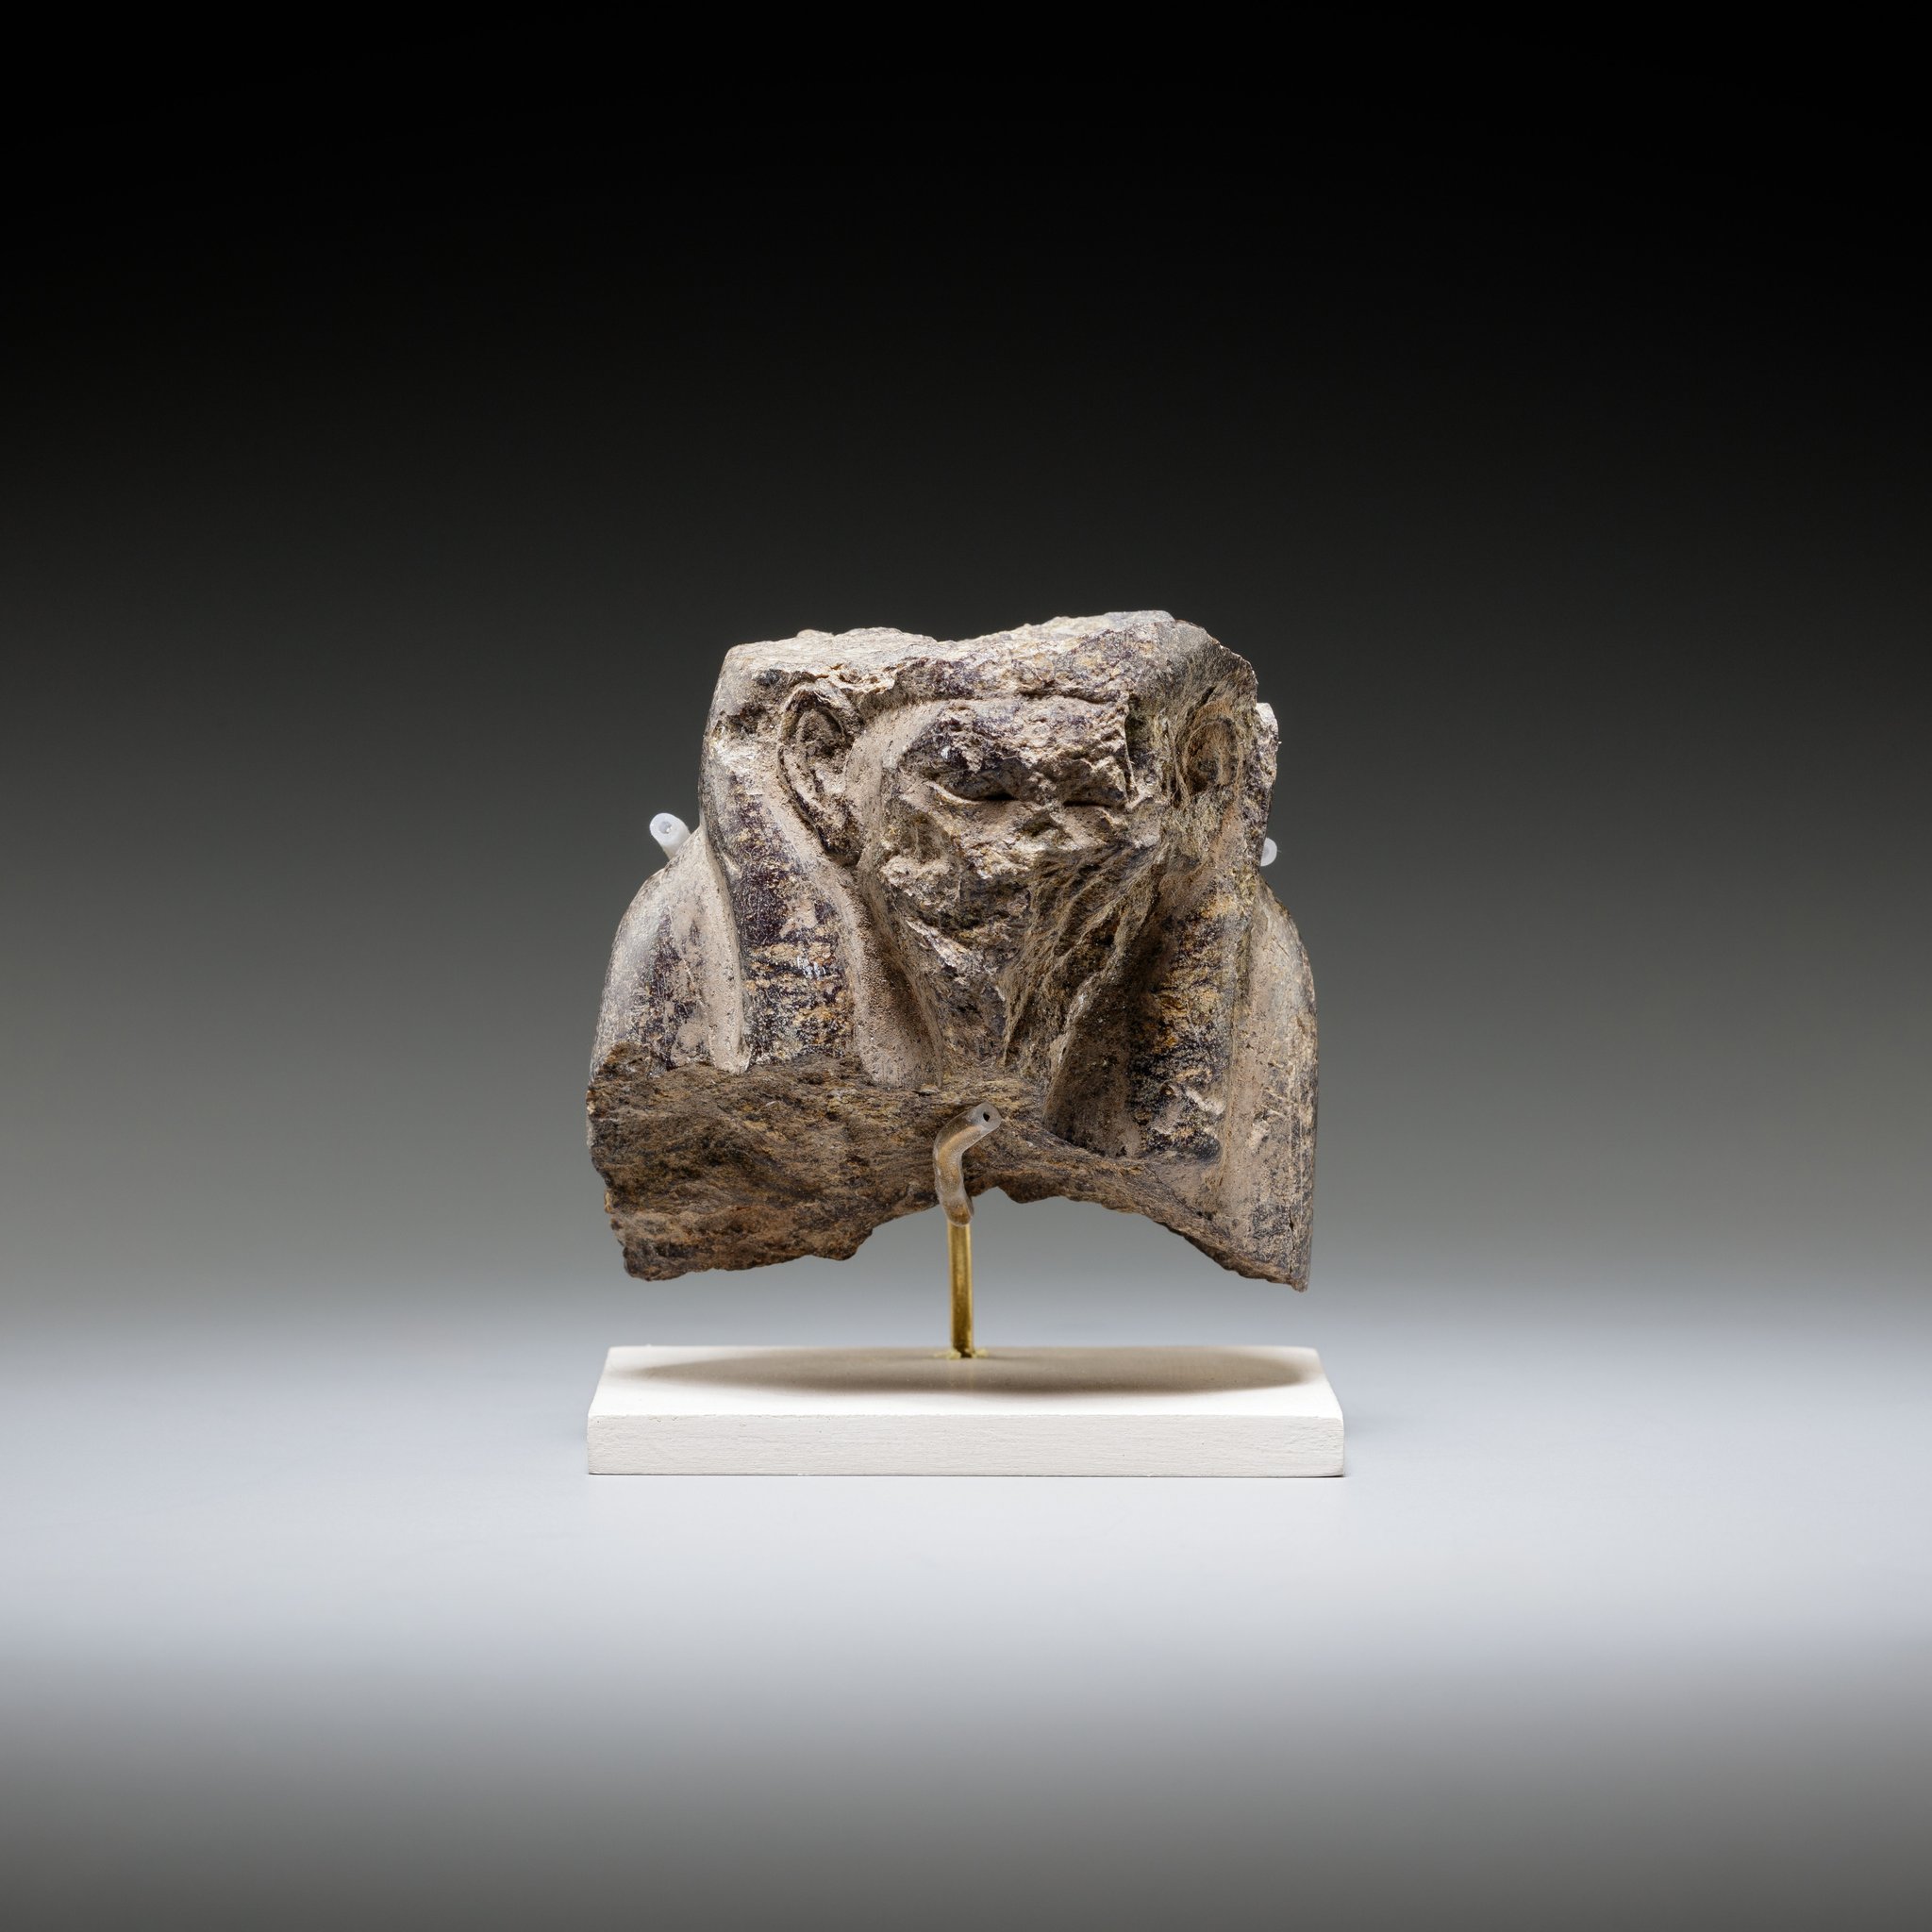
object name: statue fragment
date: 1295-1070 BCE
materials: stone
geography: egypt